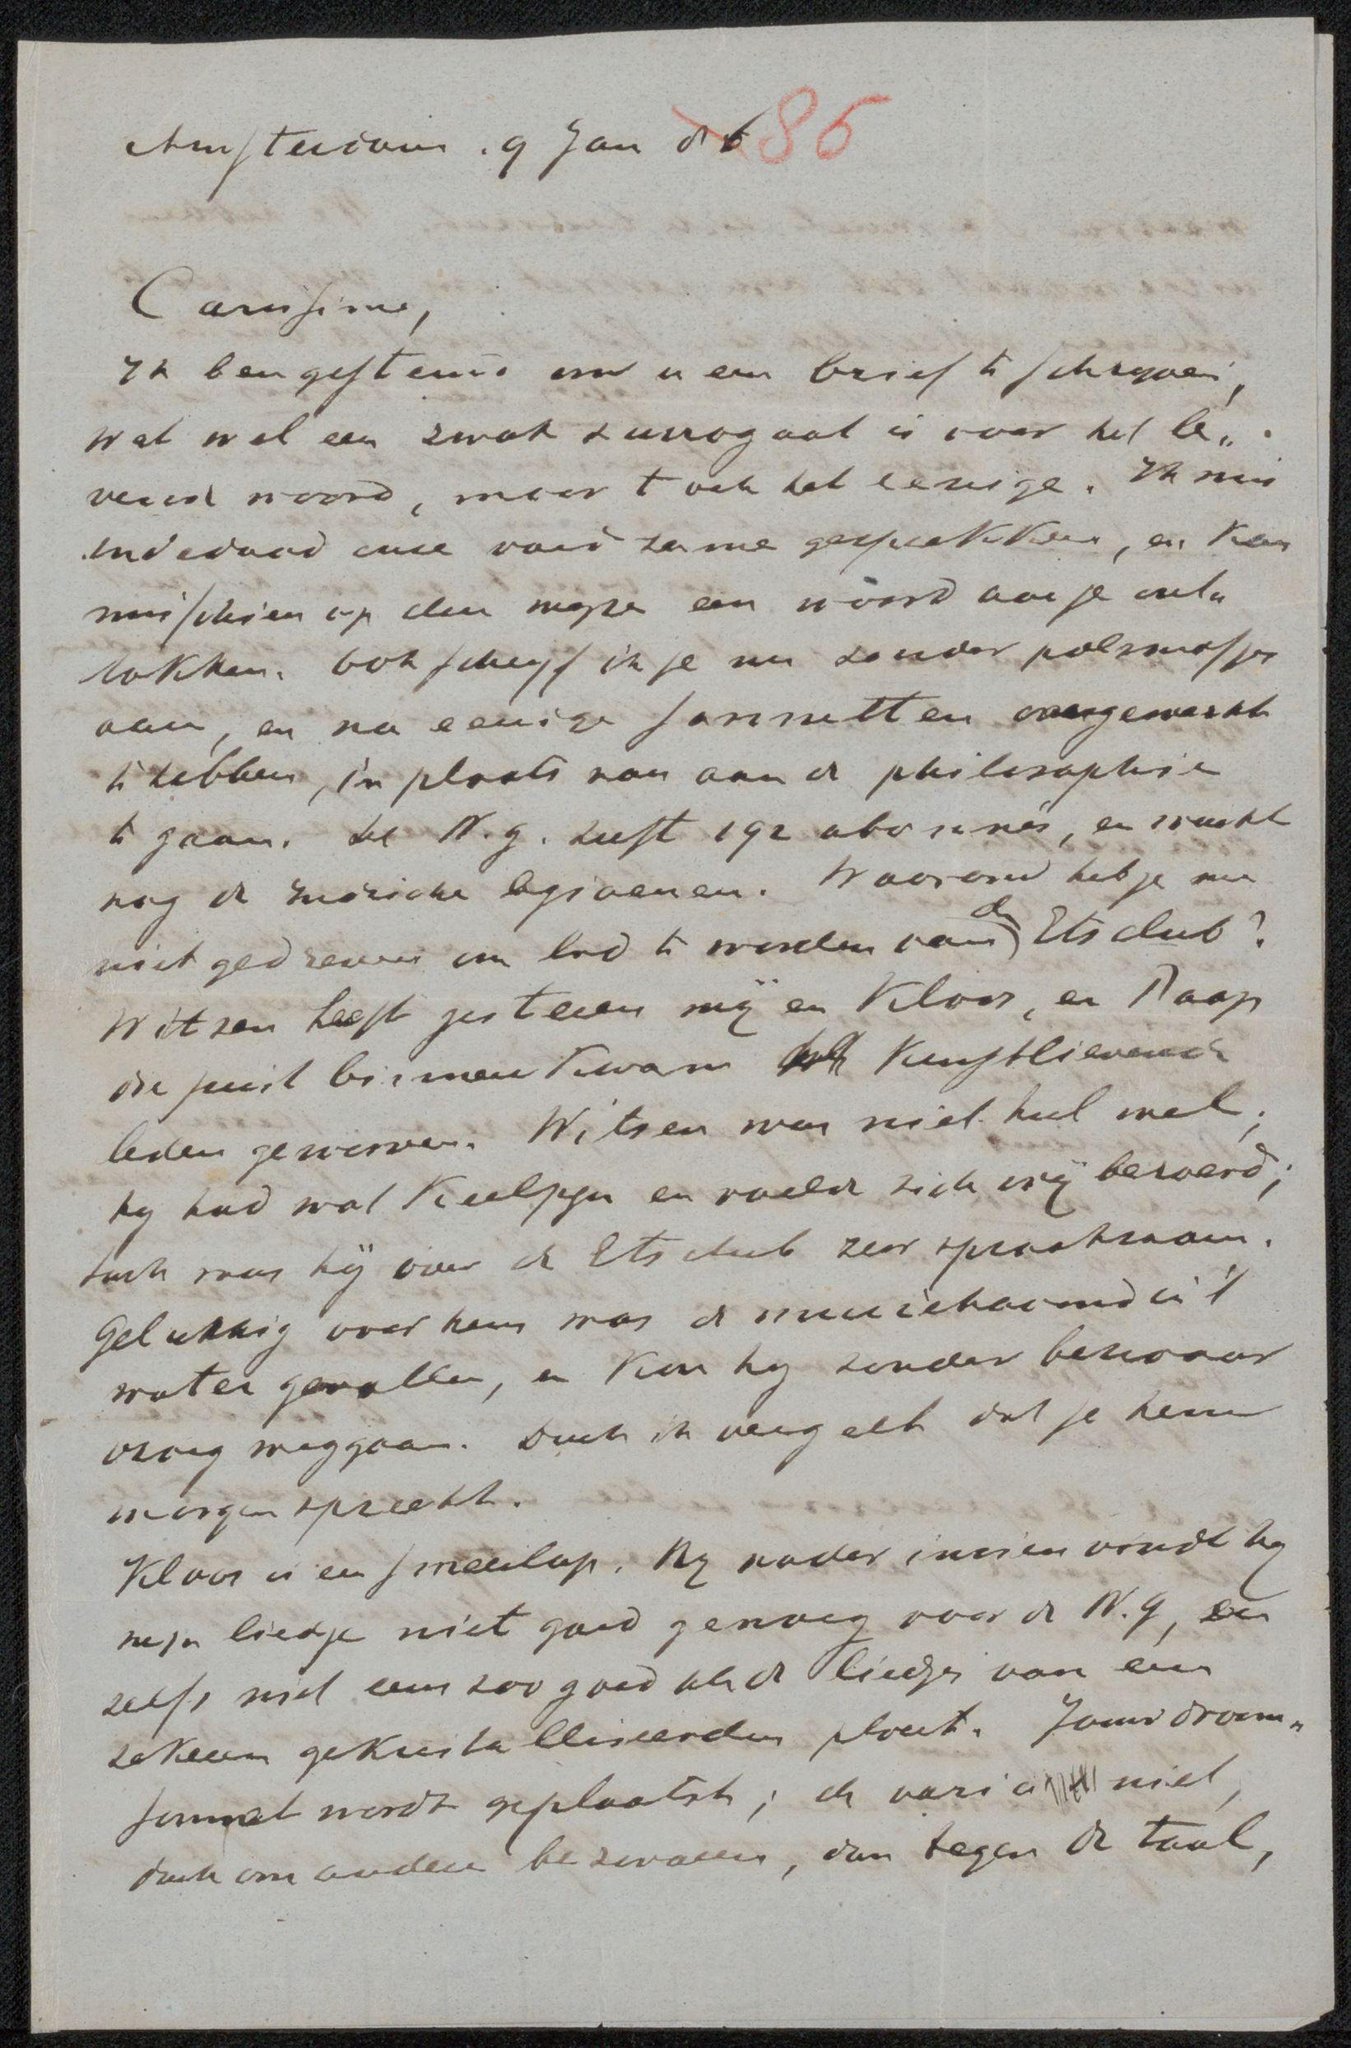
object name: letter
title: Brief aan Jan Veth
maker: chap van deventer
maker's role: kunstcriticus, scheikundige, schrijver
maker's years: 1860-1931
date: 1886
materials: ink, paper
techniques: pen, writing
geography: amsterdam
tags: dordrecht, designer, jan veth, painter, print maker, draughtsman, willem witsen, willem kloos, albert verwey, diseases, historical persons (portraits and scenes from the life)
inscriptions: collector's mark: ‘RPK’